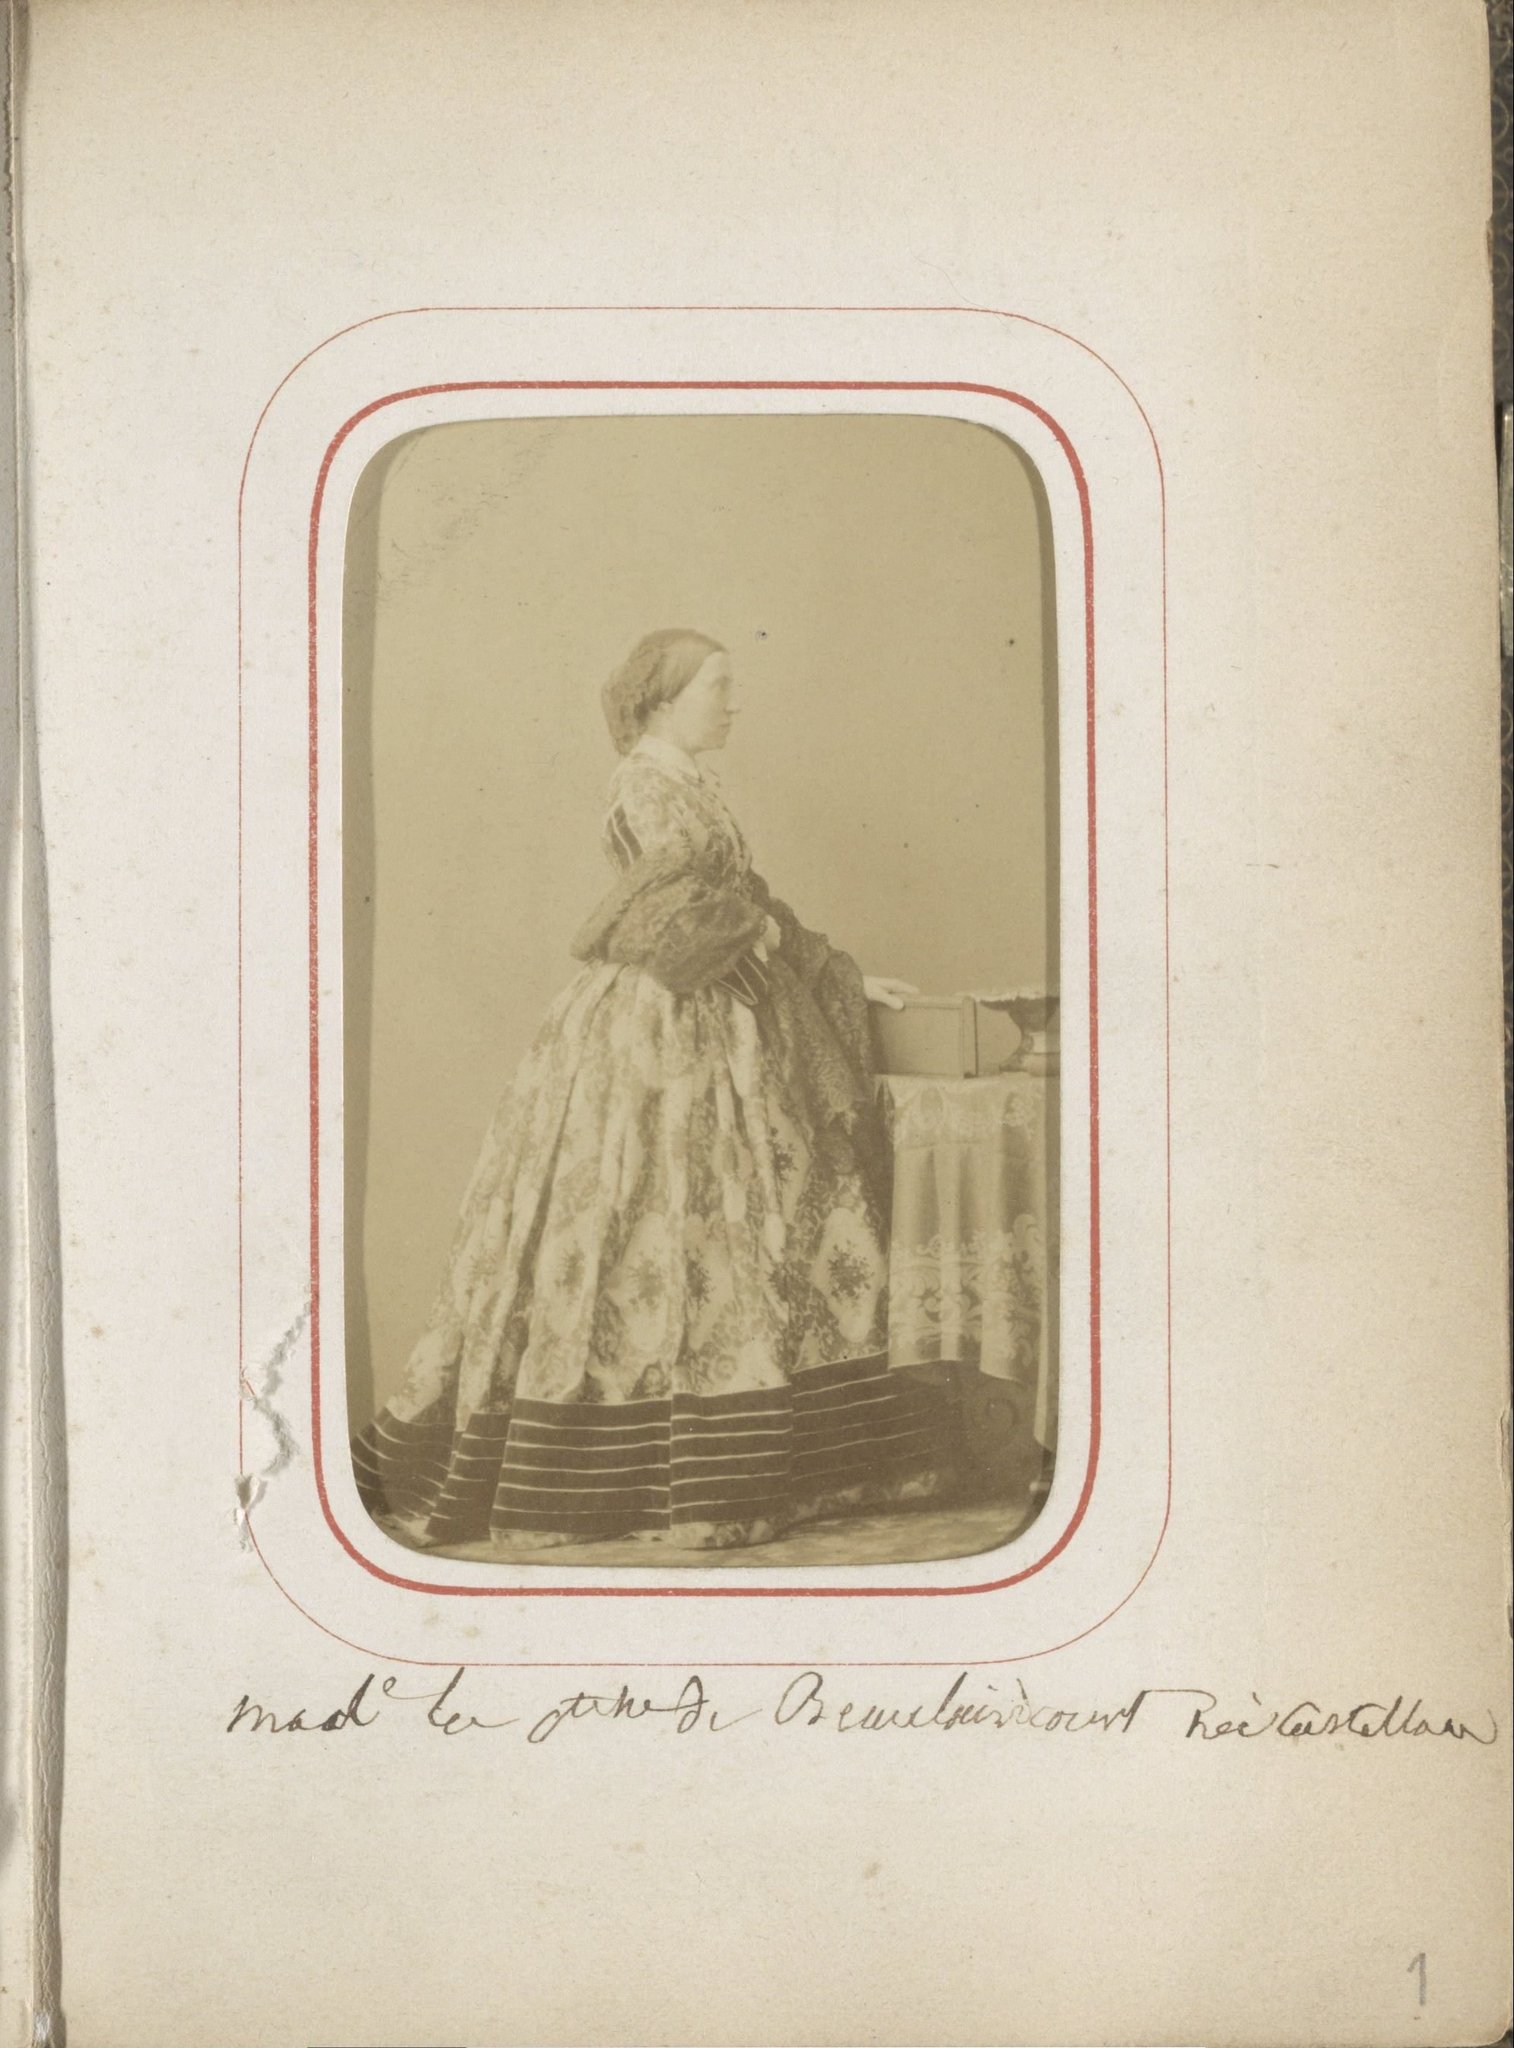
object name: carte de visite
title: Portret van gravin De Beaulaincourt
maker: Anonymous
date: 1860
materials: cardboard, paper, photographic support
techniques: albumen print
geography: naples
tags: studio requisites ~ photographer, historical persons, styles of hairdress - aa - ~ women, dress, gown, naples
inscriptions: date: ‘1860’, address: ‘Naples’, name: ‘Mad.e la C.tesse de Beaulaincourt née Castellane’